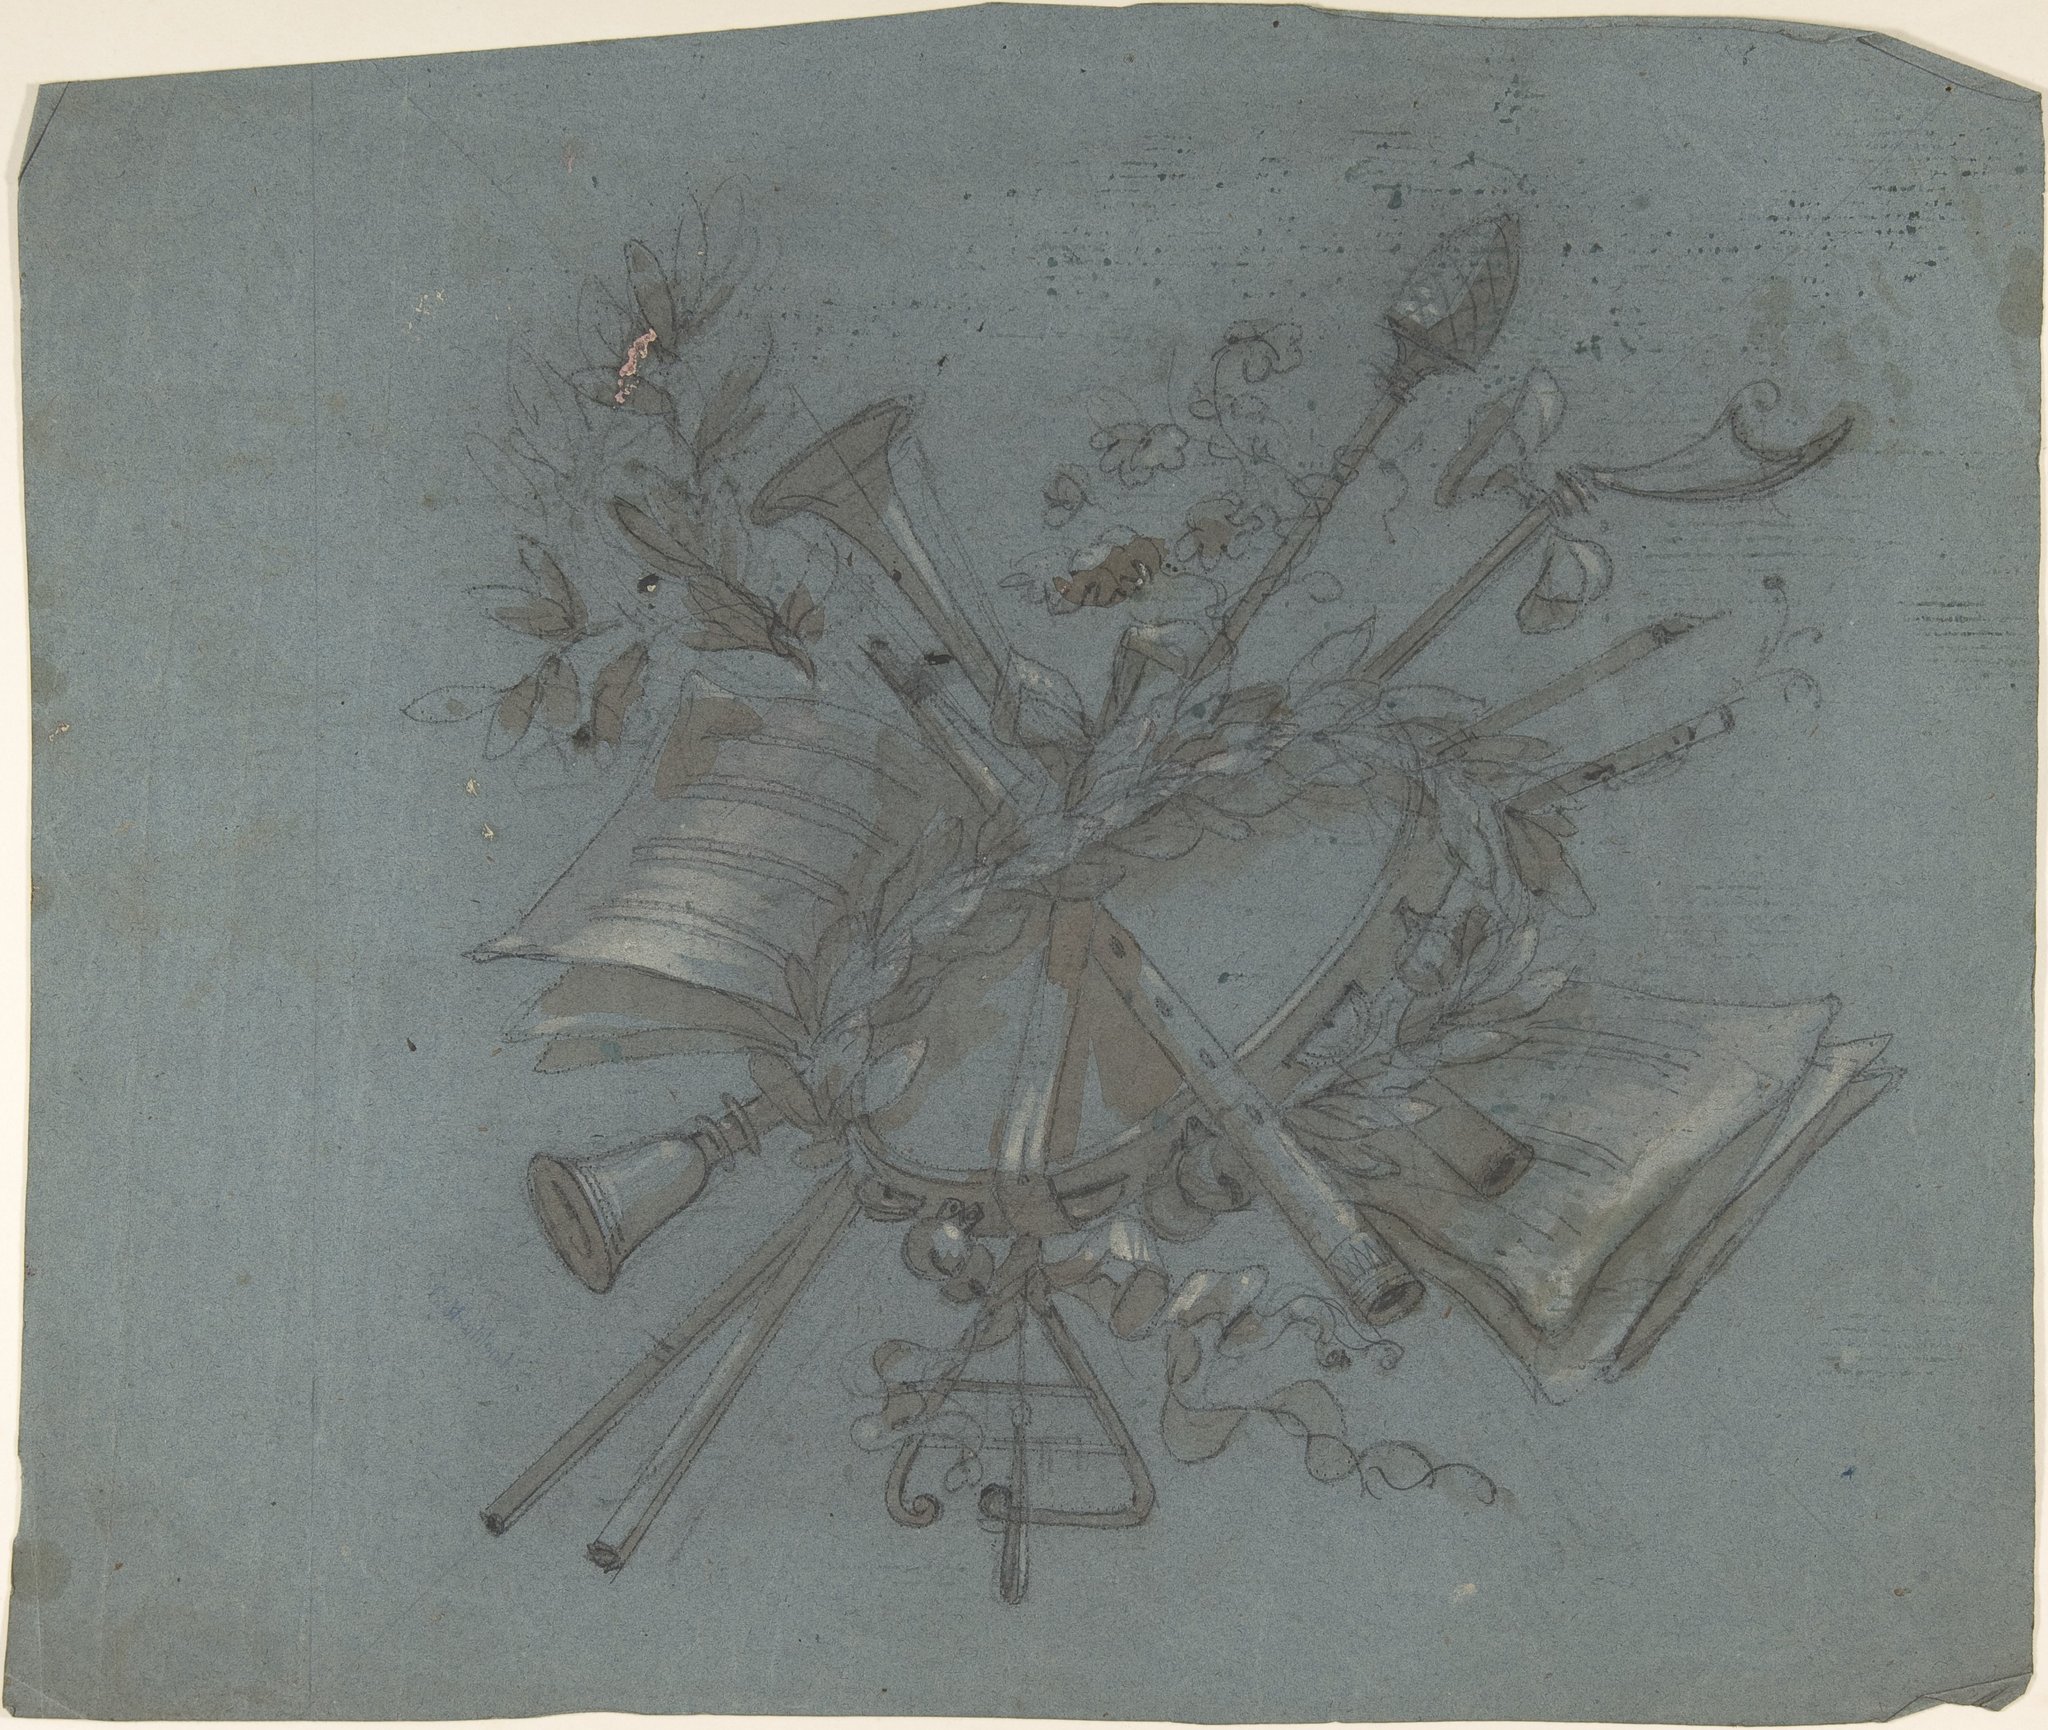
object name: drawing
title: Musical Trophy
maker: charles monblond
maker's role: artist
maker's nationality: french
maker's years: 1800-1900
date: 1801-1900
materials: chalk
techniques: brush, heightening, transfer, wash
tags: musical instruments,trophies